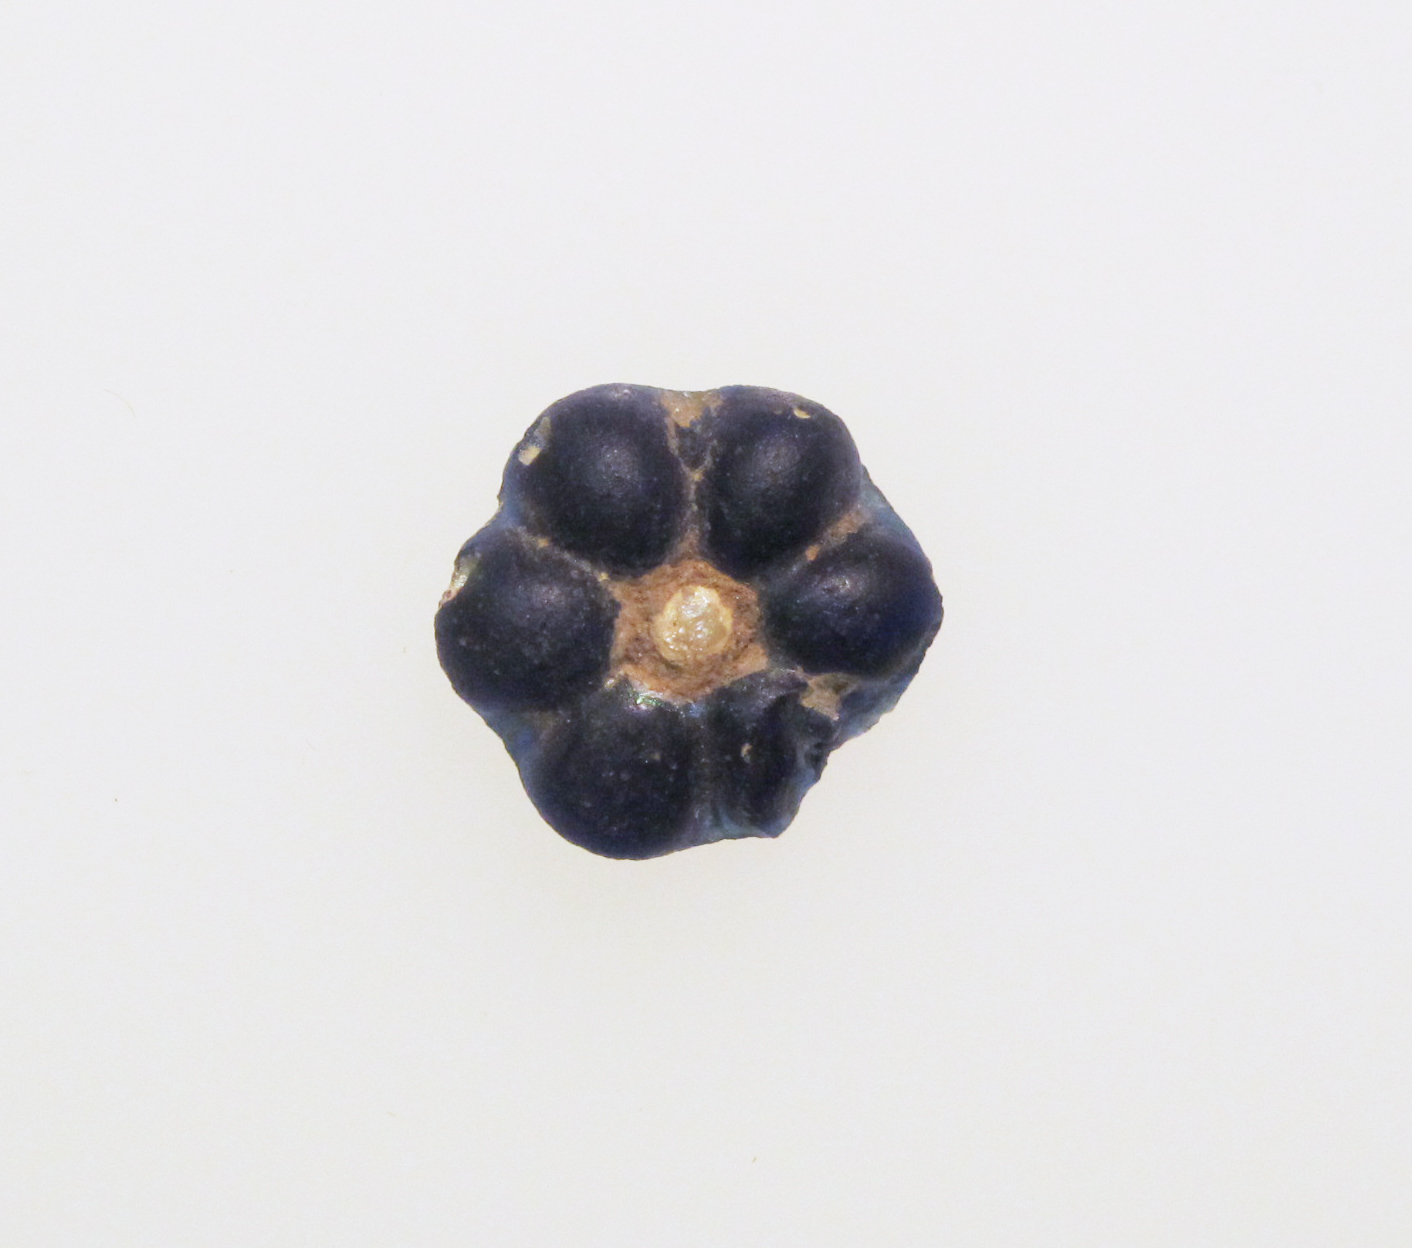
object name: bead in the form of a rosette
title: Glass bead in the form of a rosette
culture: roman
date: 1-33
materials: glass